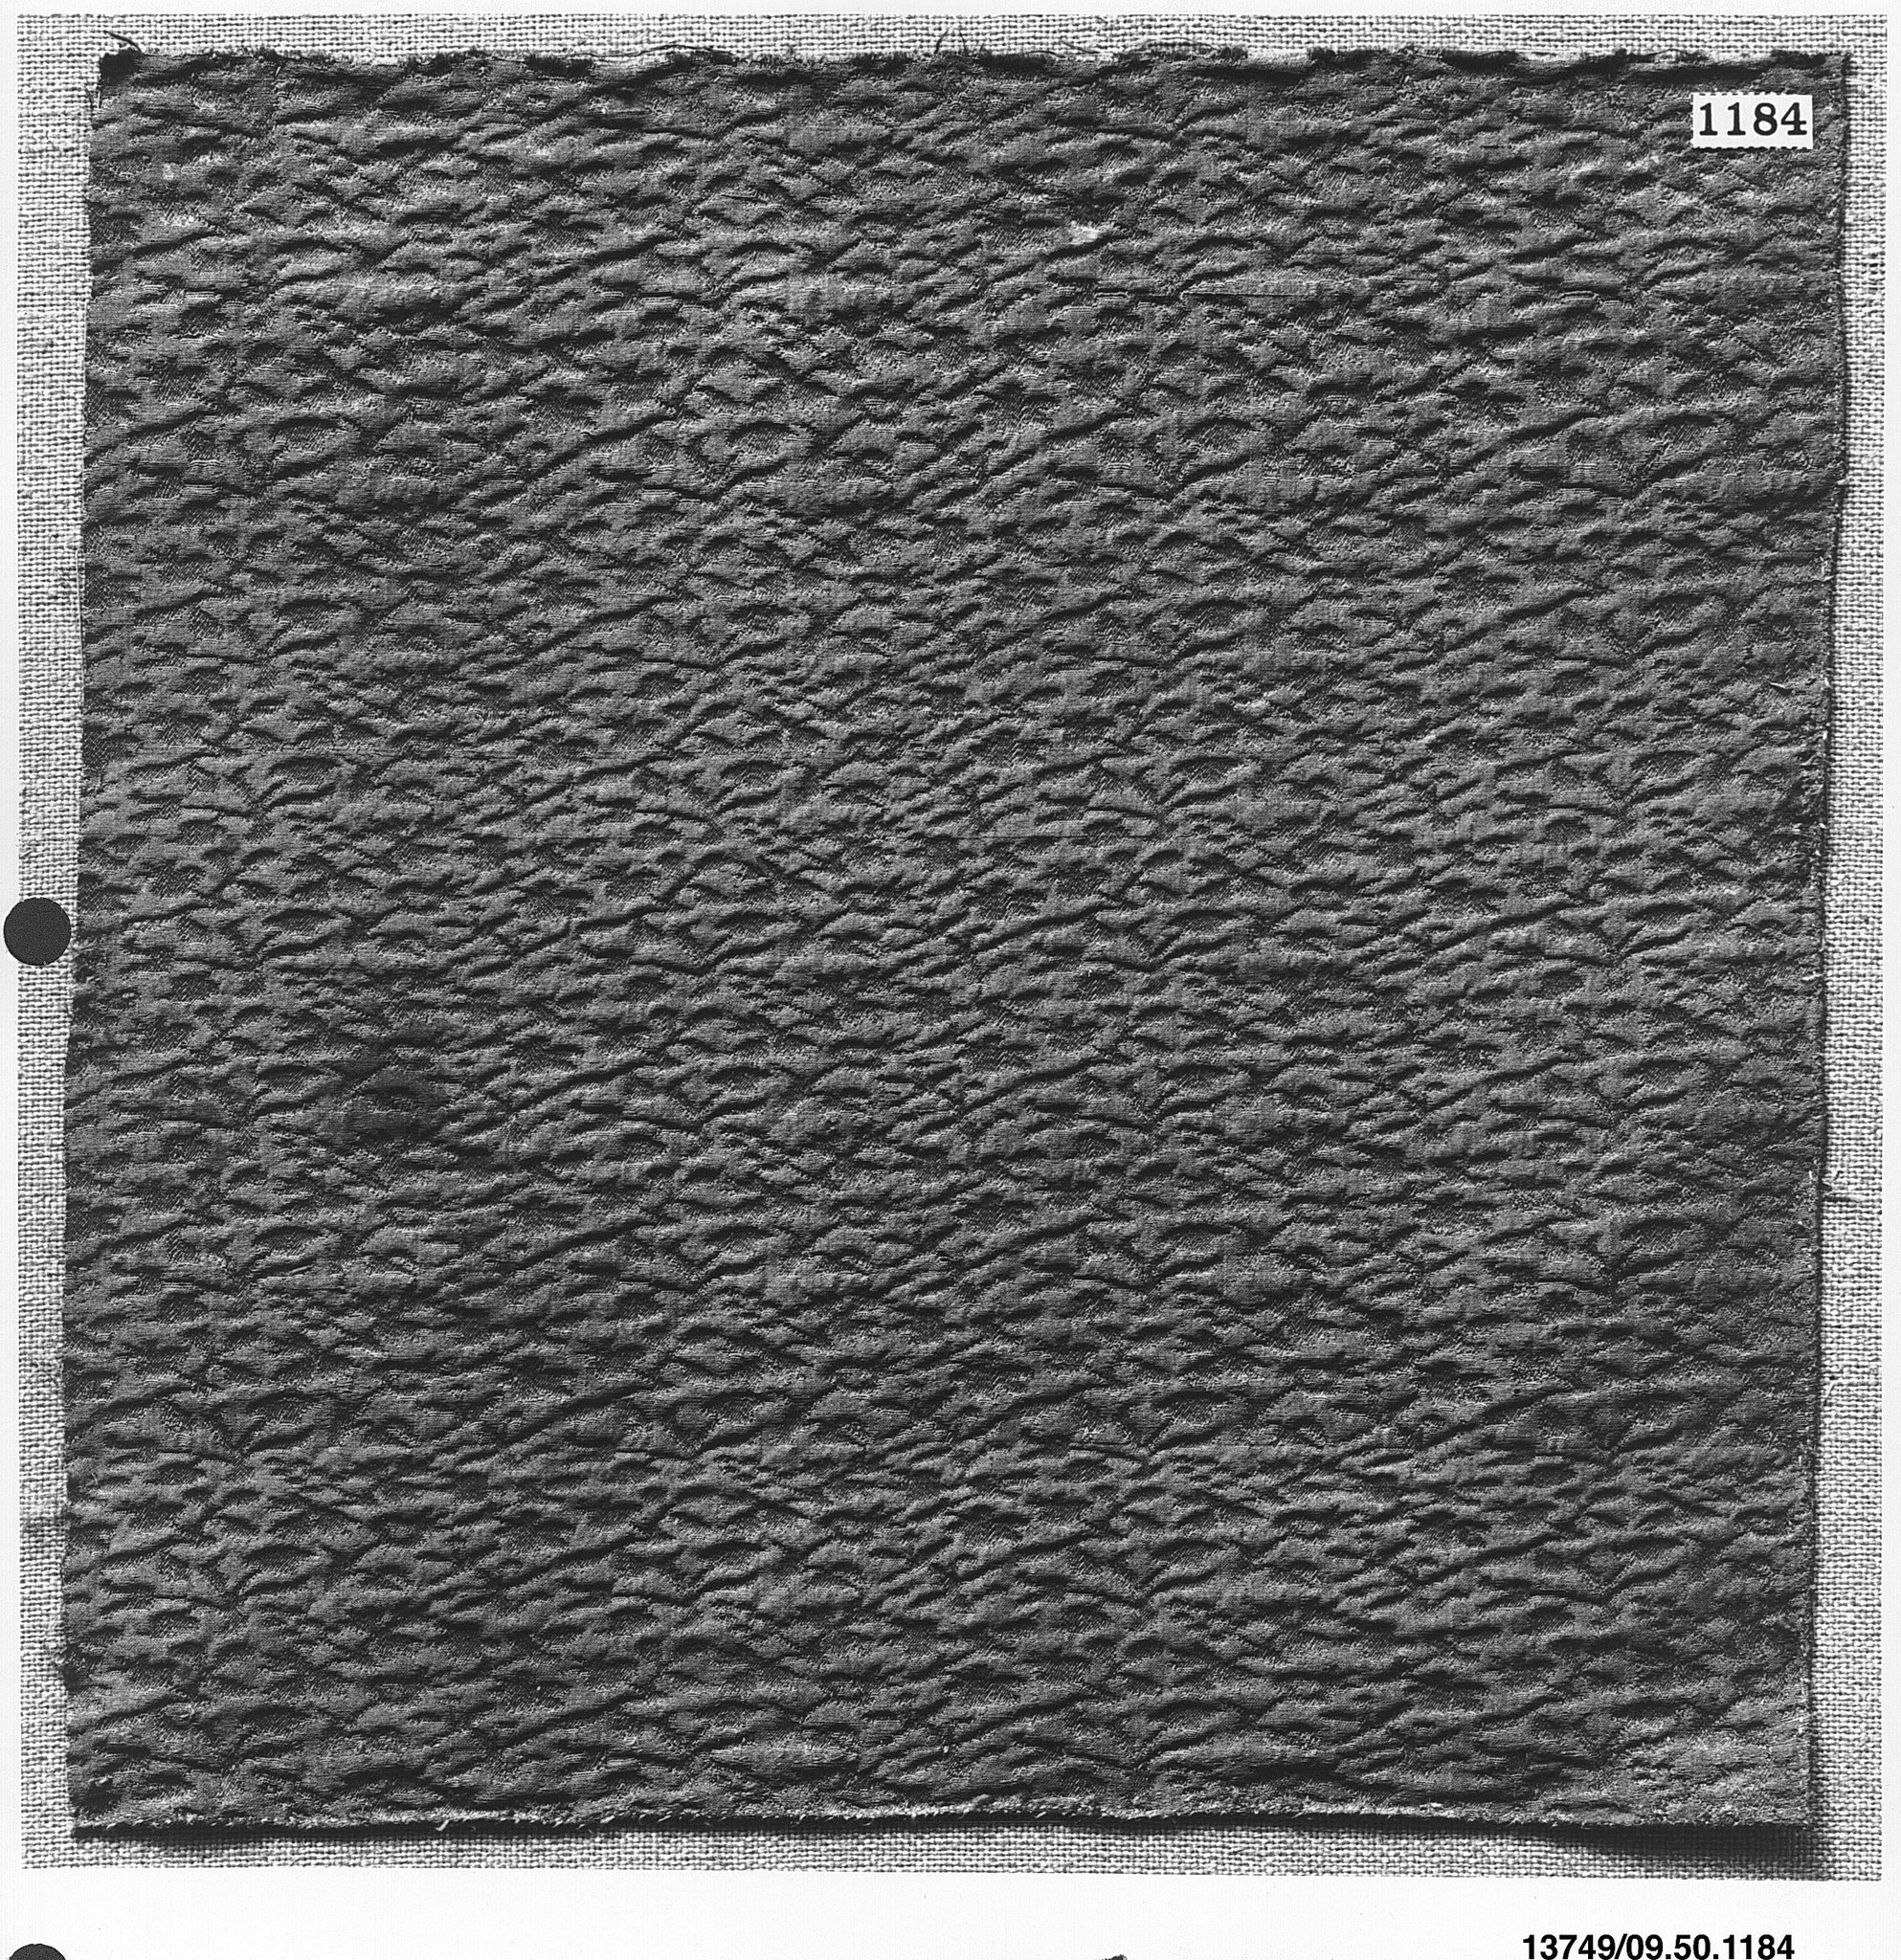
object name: piece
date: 1501-1600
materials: silk